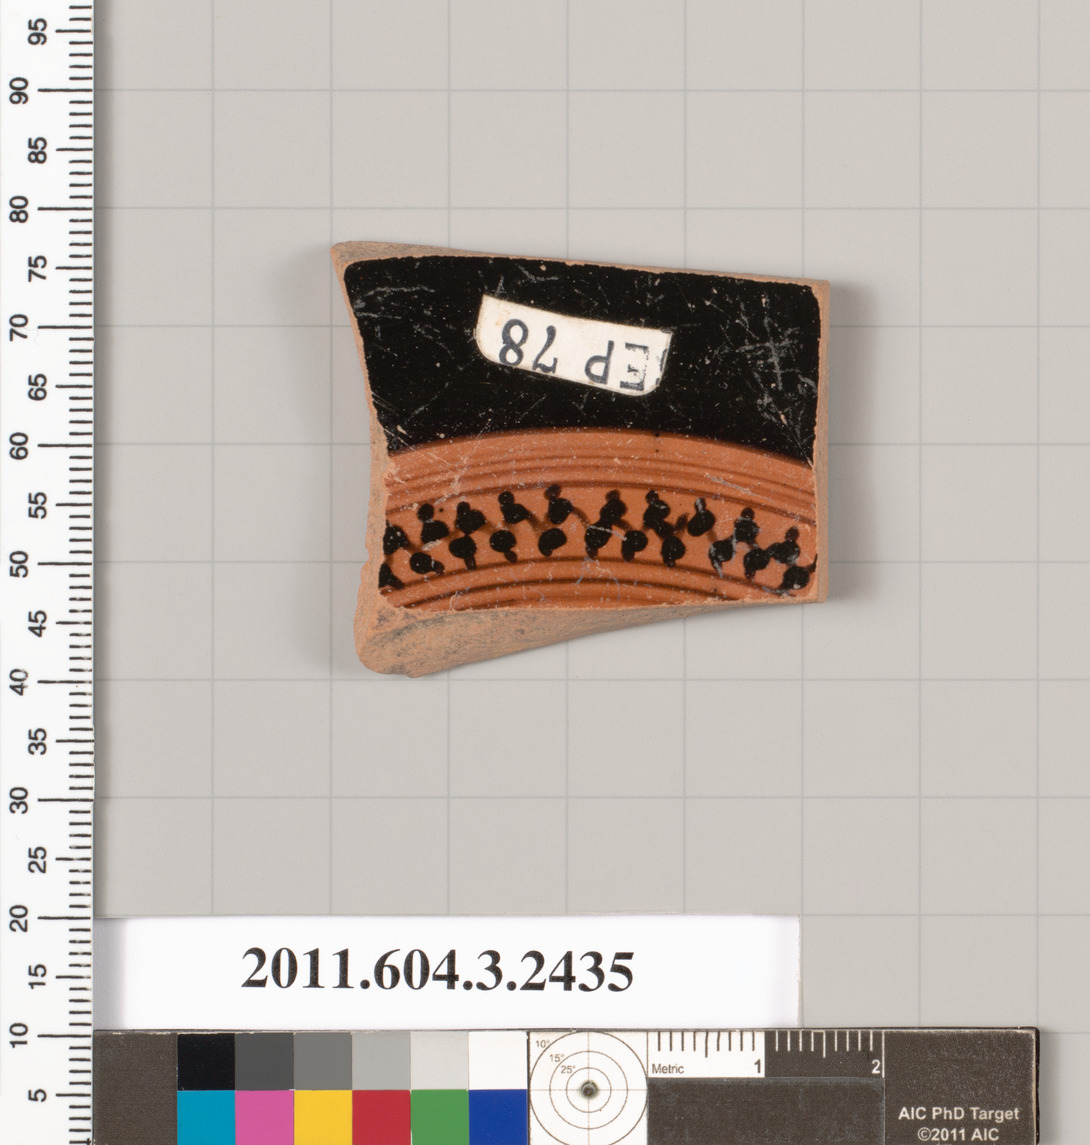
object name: kylix fragment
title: Terracotta fragment of a kylix (drinking cup)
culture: greek, attic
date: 525-501 BCE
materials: terracotta